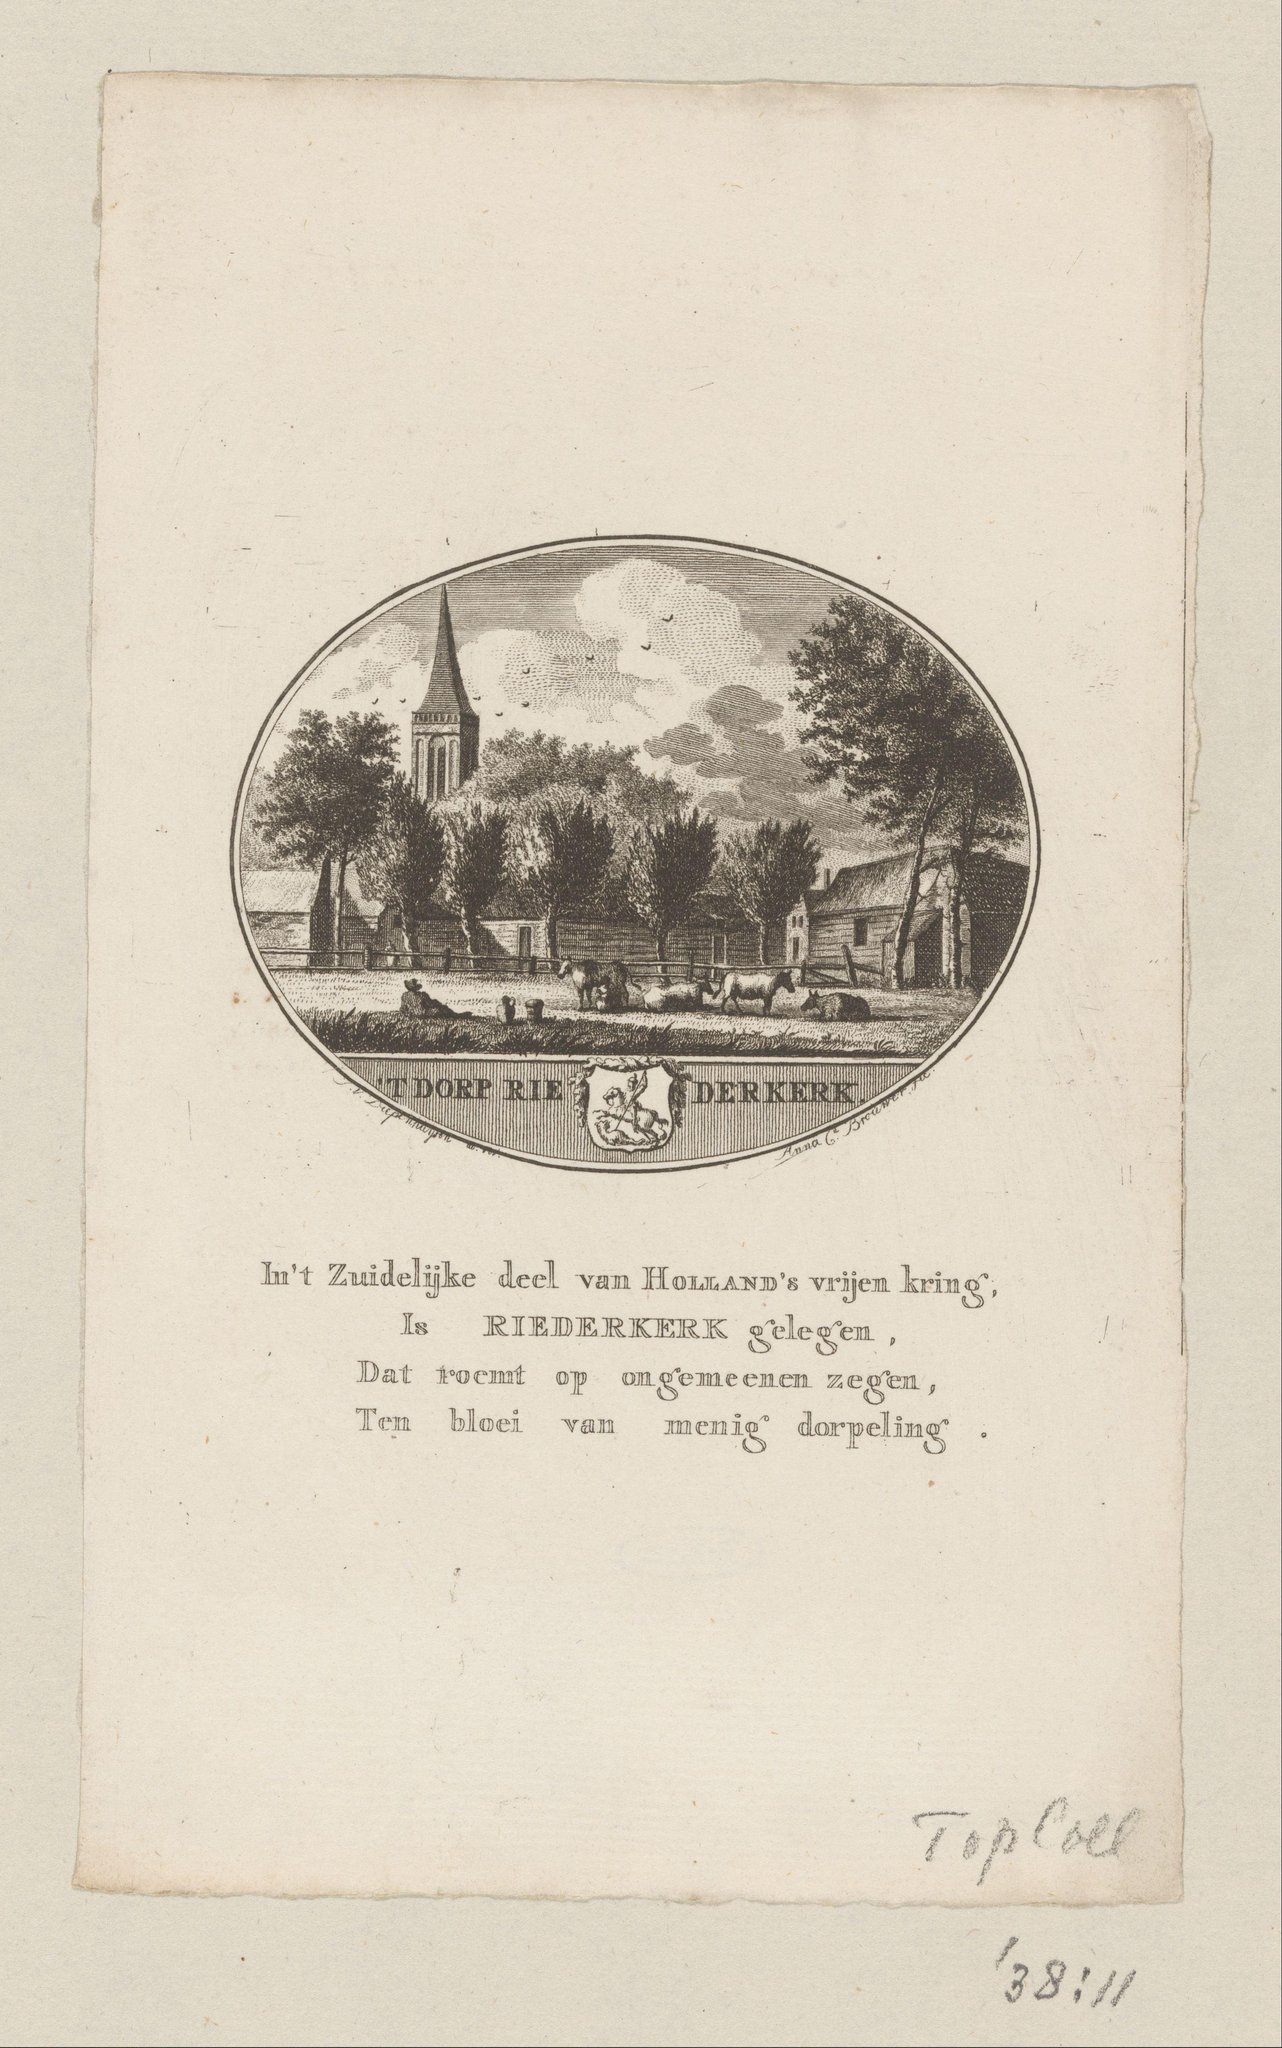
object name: book illustration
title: Gezicht op het dorp Ridderkerk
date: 1793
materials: paper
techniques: etching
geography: amsterdam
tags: prospect of village, silhouette of village, church (exterior)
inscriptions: collector's mark: Lugt 2228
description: Prent uit: Ollefen, L. van. De Nederlandsche stad- en dorpbeschrijver. 8 dln. Amsterdam: H.A. Banse, 1793-1801, dl. 1 (1793).